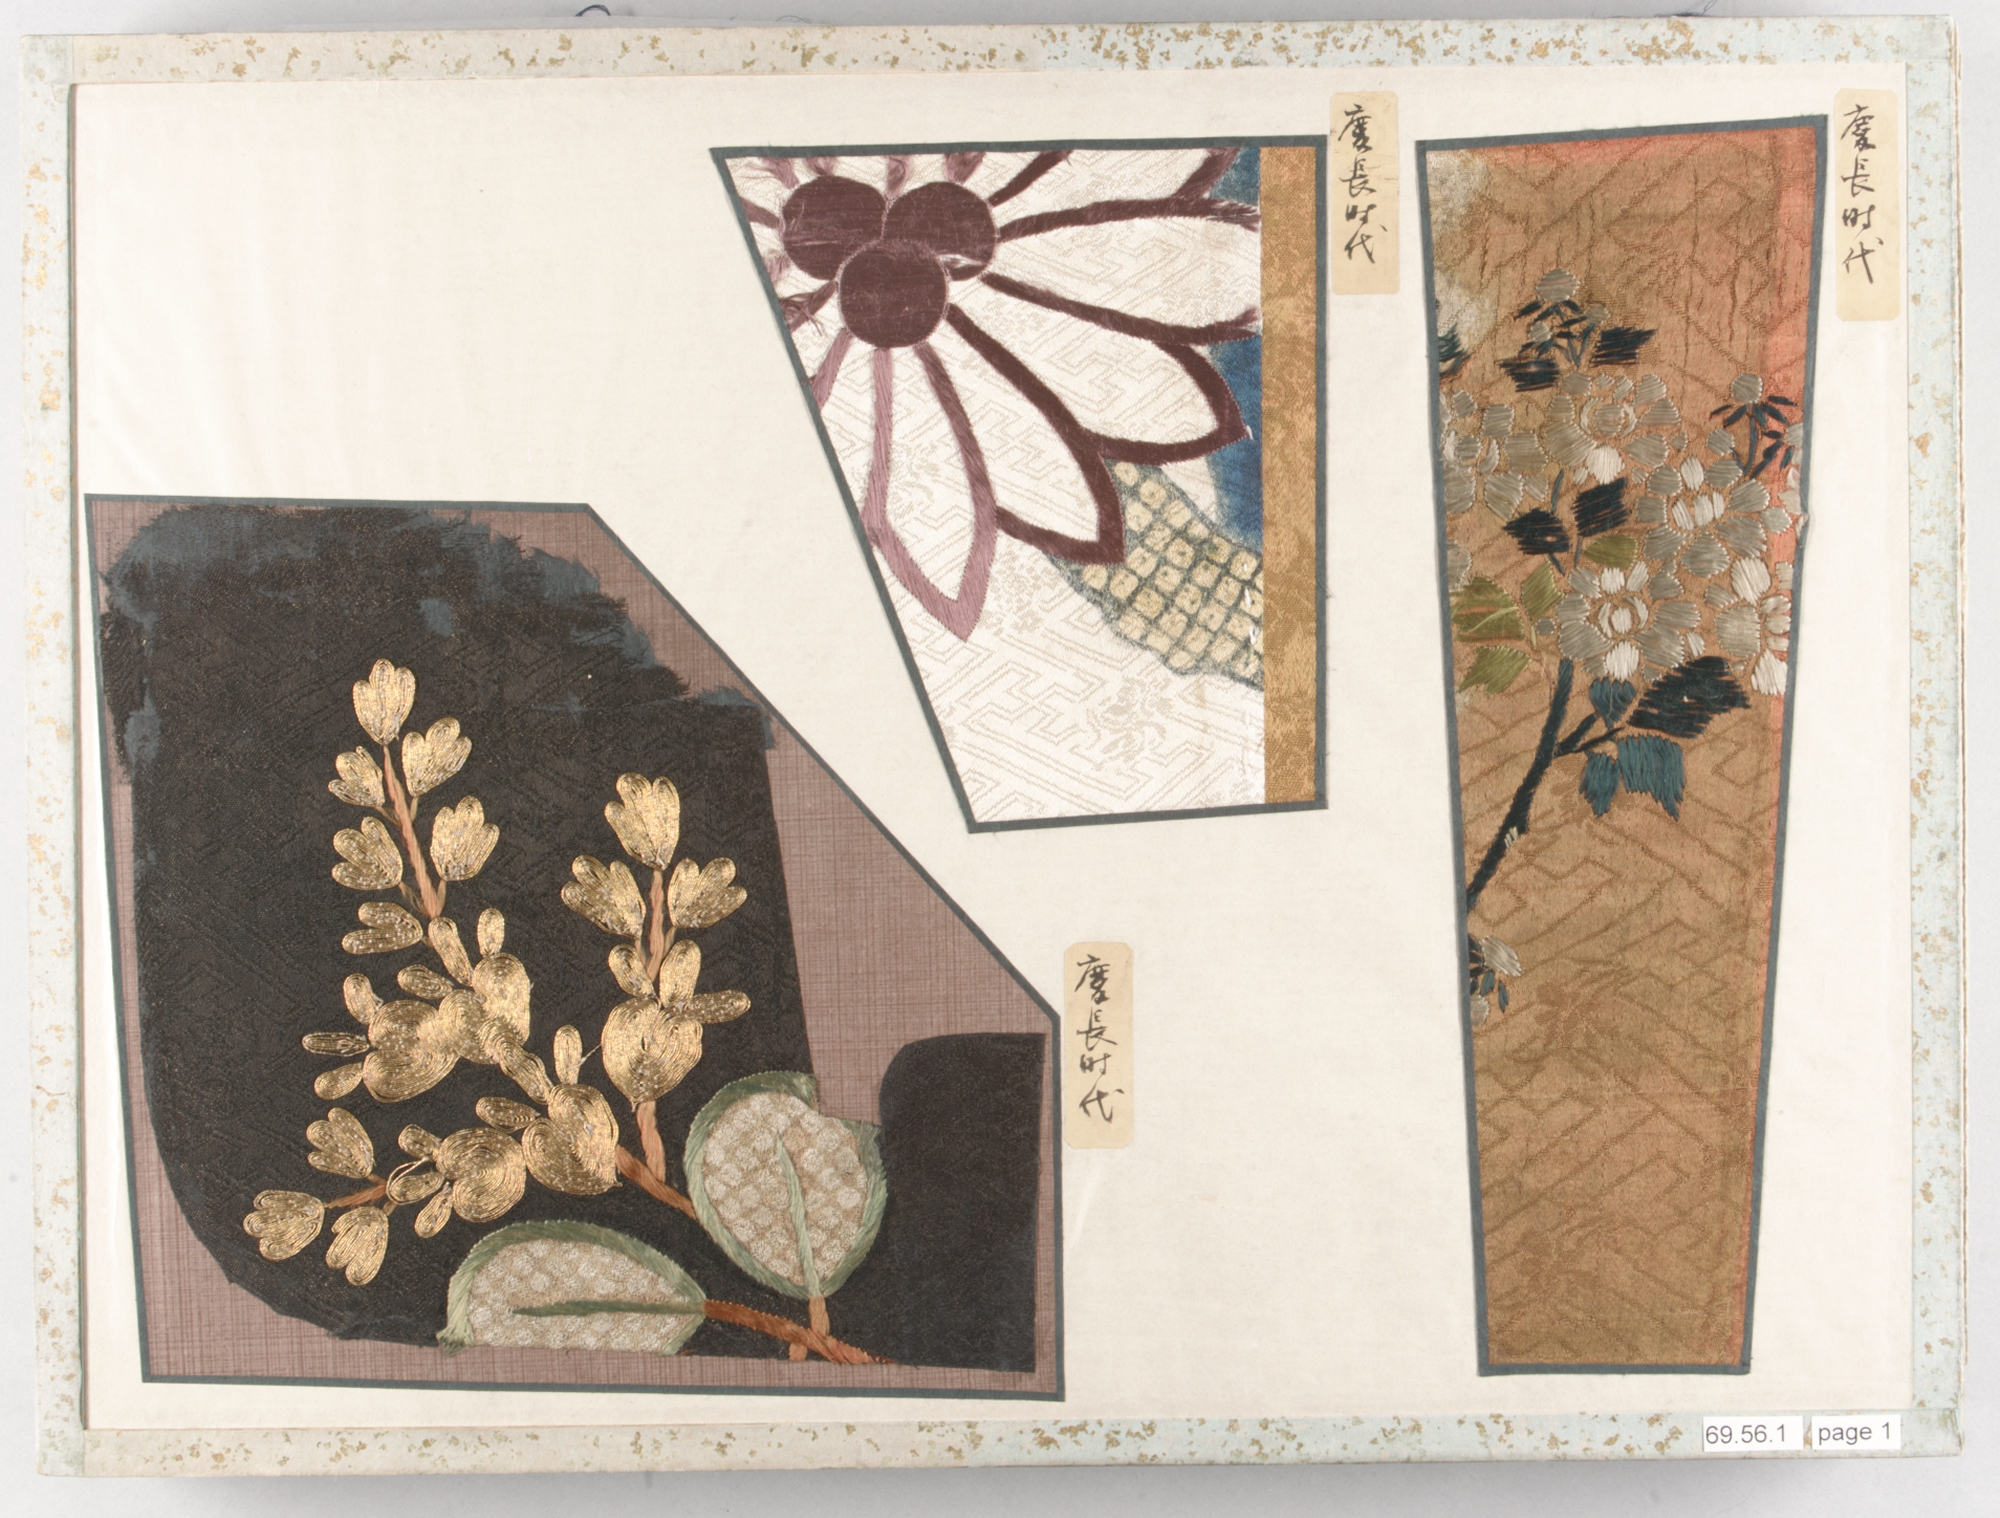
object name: book of silk fragment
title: Connoisseur’s Album of Edo-Period Silk Fragments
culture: japanese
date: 1801-1900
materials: textile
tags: flowers